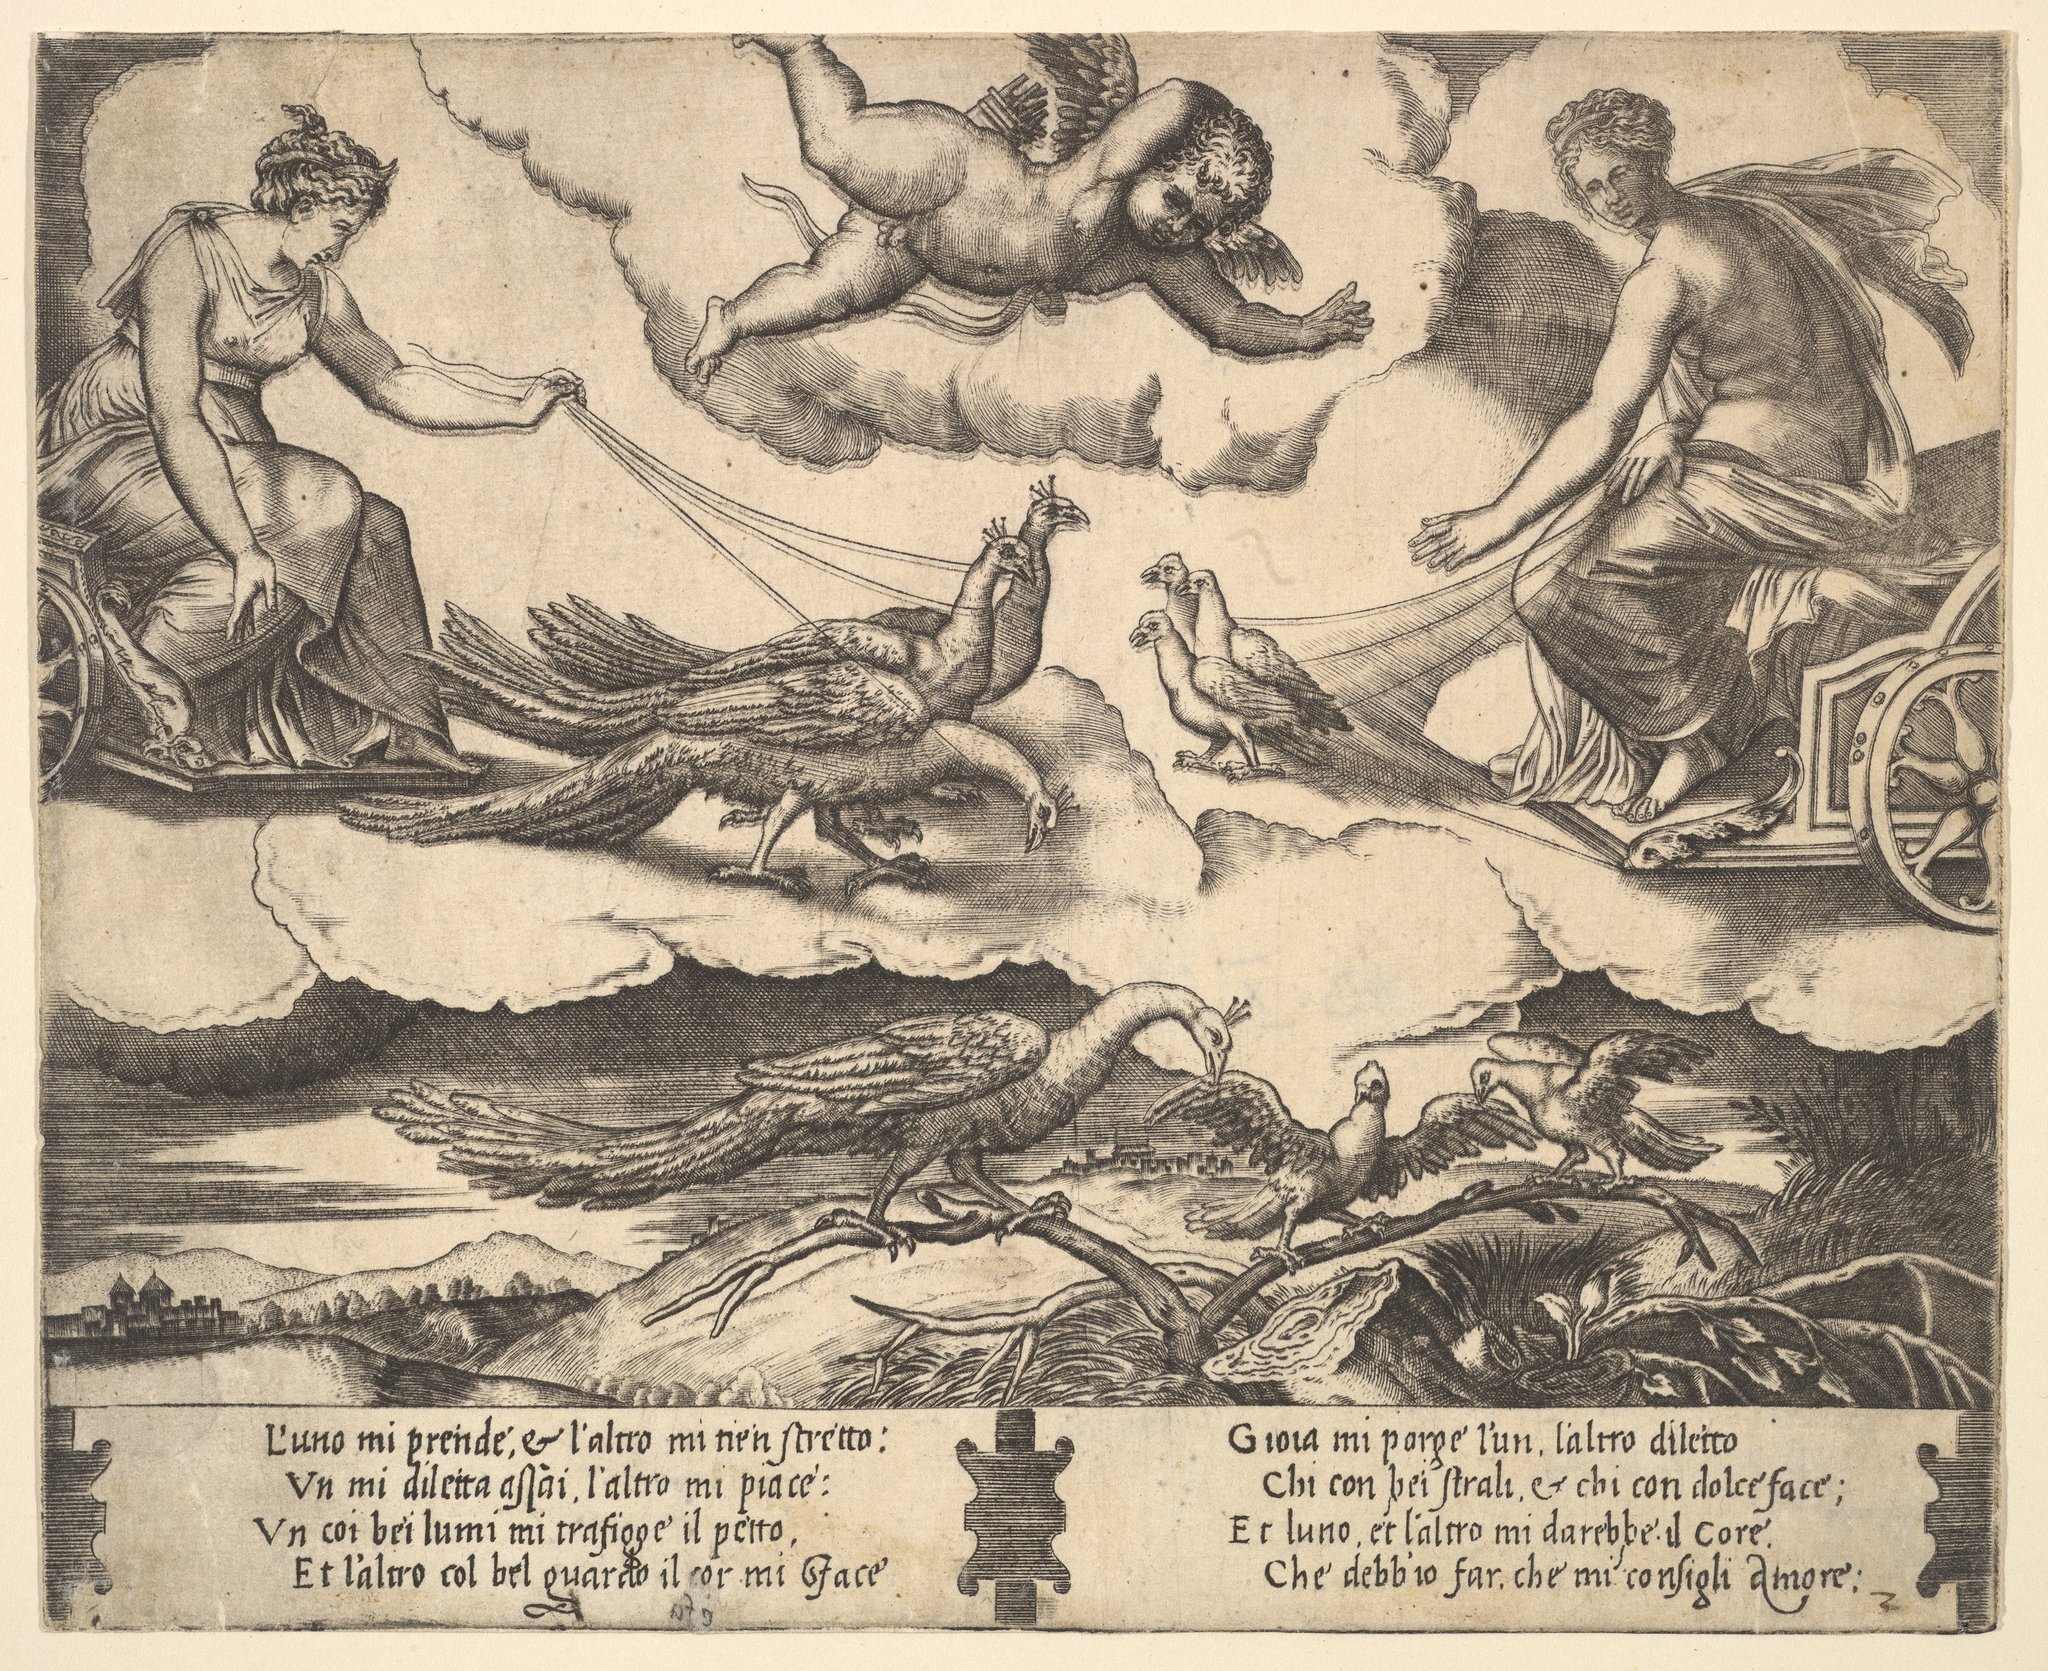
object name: print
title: Allegory of Marriage and Love; Juno in a chariot drawn by peacocks at left, Venus in a chariot drawn by three doves at the right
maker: master of the die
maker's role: artist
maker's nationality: italian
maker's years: 1525-1560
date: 1530-1560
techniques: engraving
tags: doves,putti,juno,venus,peacocks,chariots